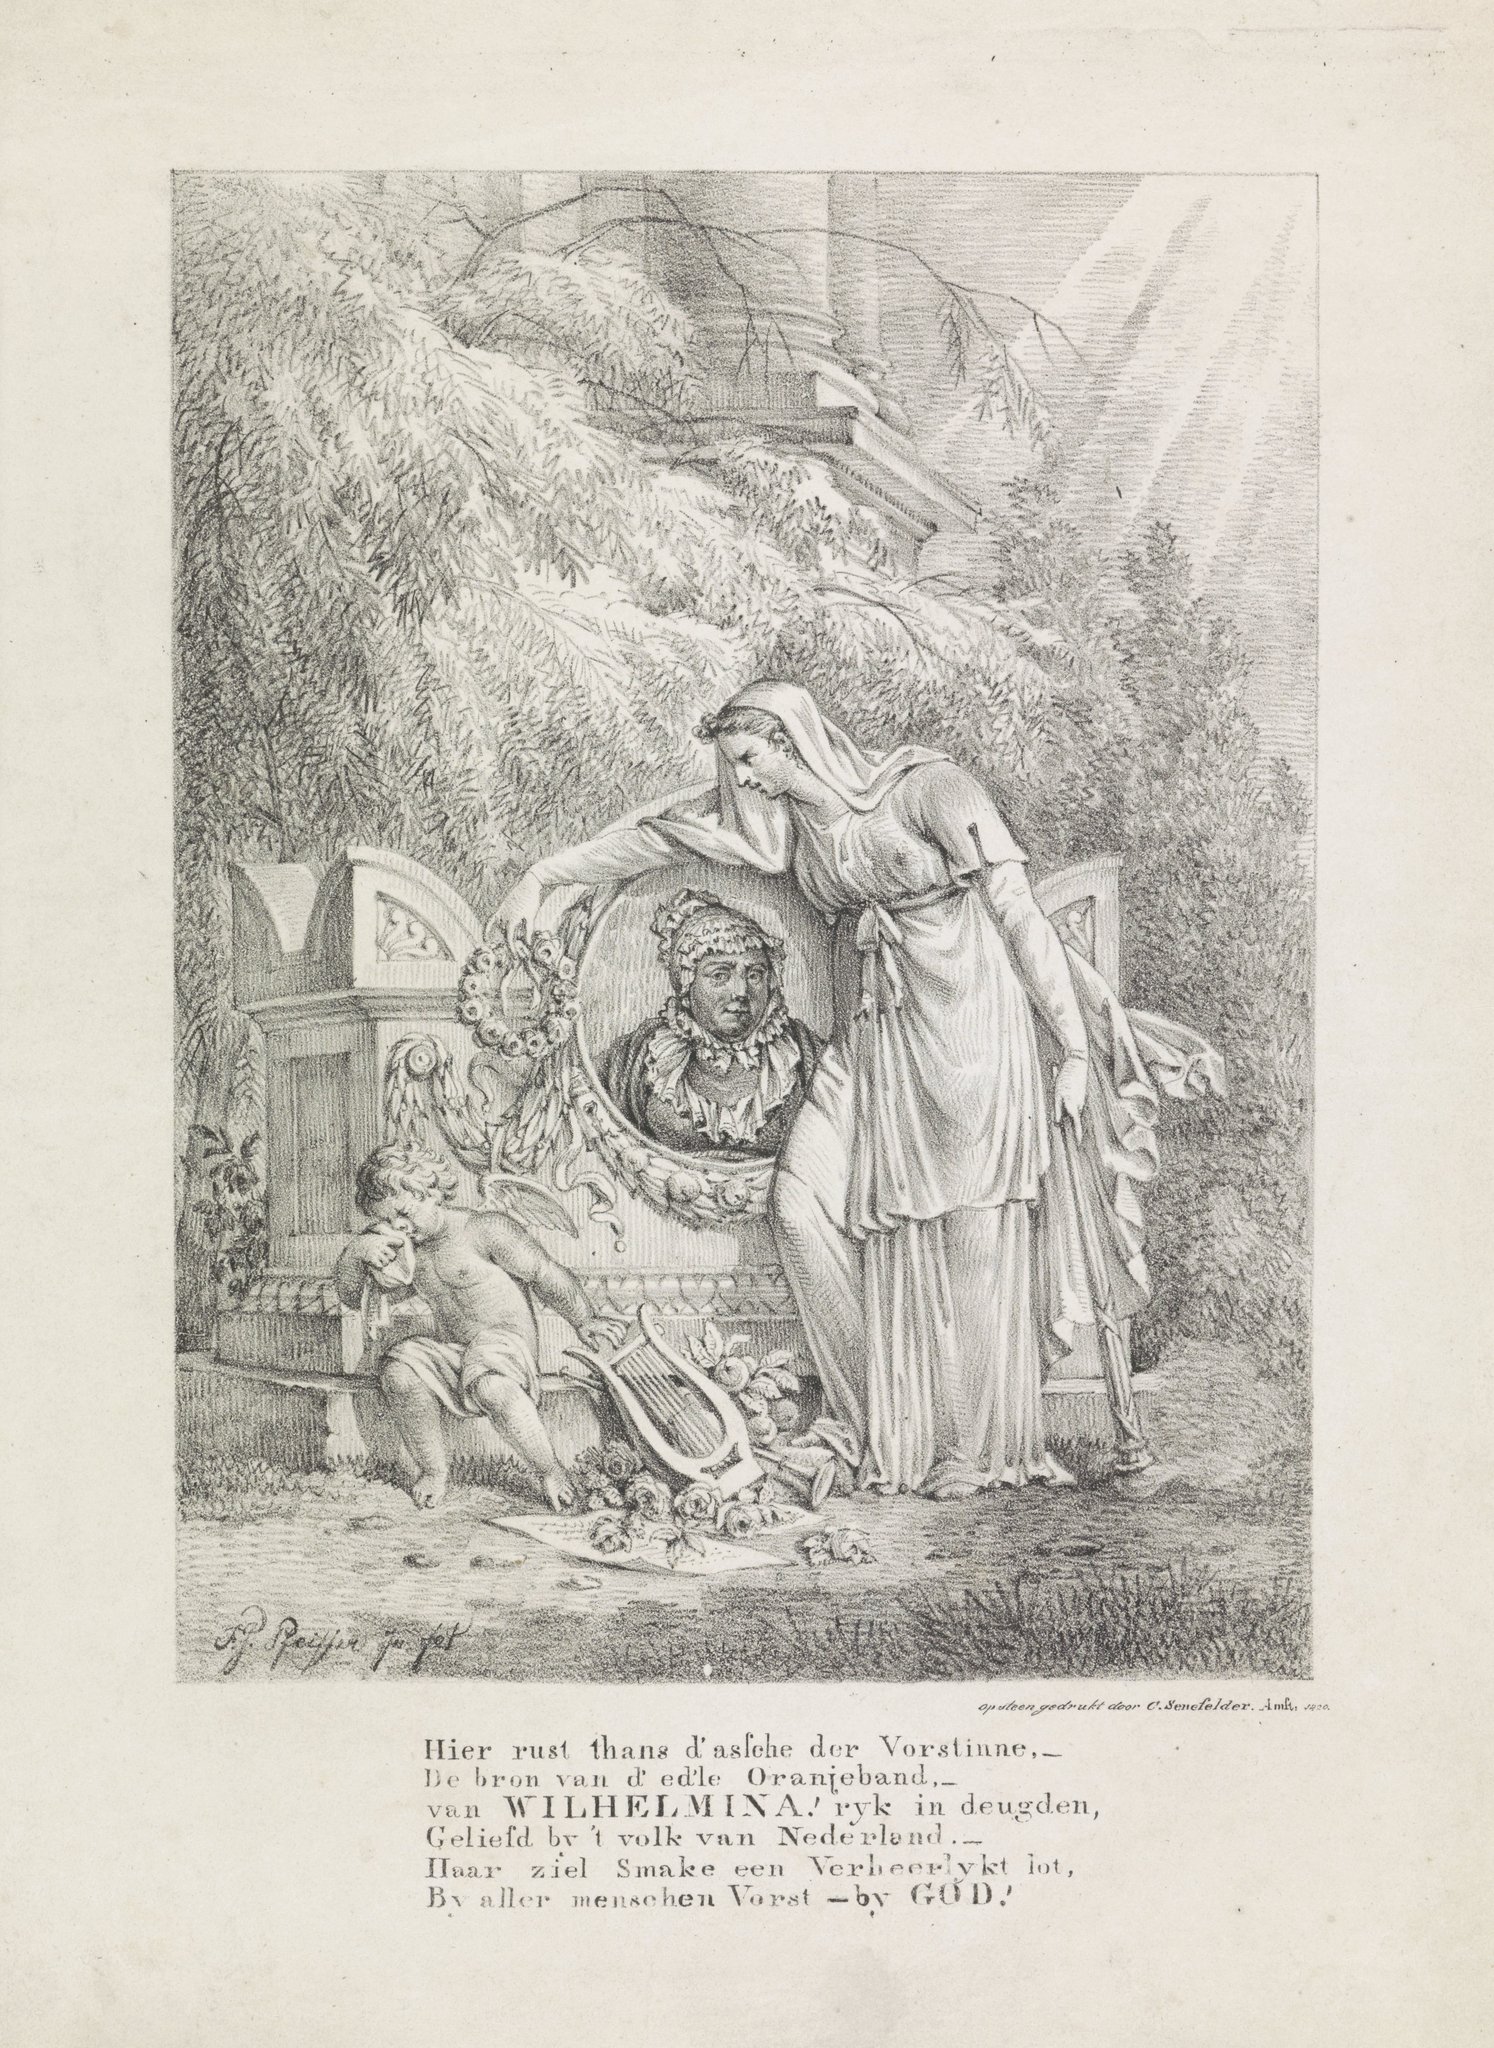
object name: print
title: Allegorie op de dood van prinses Wilhelmina van Pruisen, 1820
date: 1820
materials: paper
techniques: lithograph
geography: amsterdam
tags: berlin, draughtsman, wilhelmina of prussia (princess of orange), monument, statue, grave-building, monumental tomb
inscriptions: collector's mark: Lugt 2228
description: Allegorisch grafmonument bij het overlijden van prinses-douairière Wilhelmina van Pruisen, 9 juni 1820. Een vrouw met gedoofde toorts treurt bij het graf, hierbij ook een huilende putto. Onder de afbeelding een zesregelig vers.